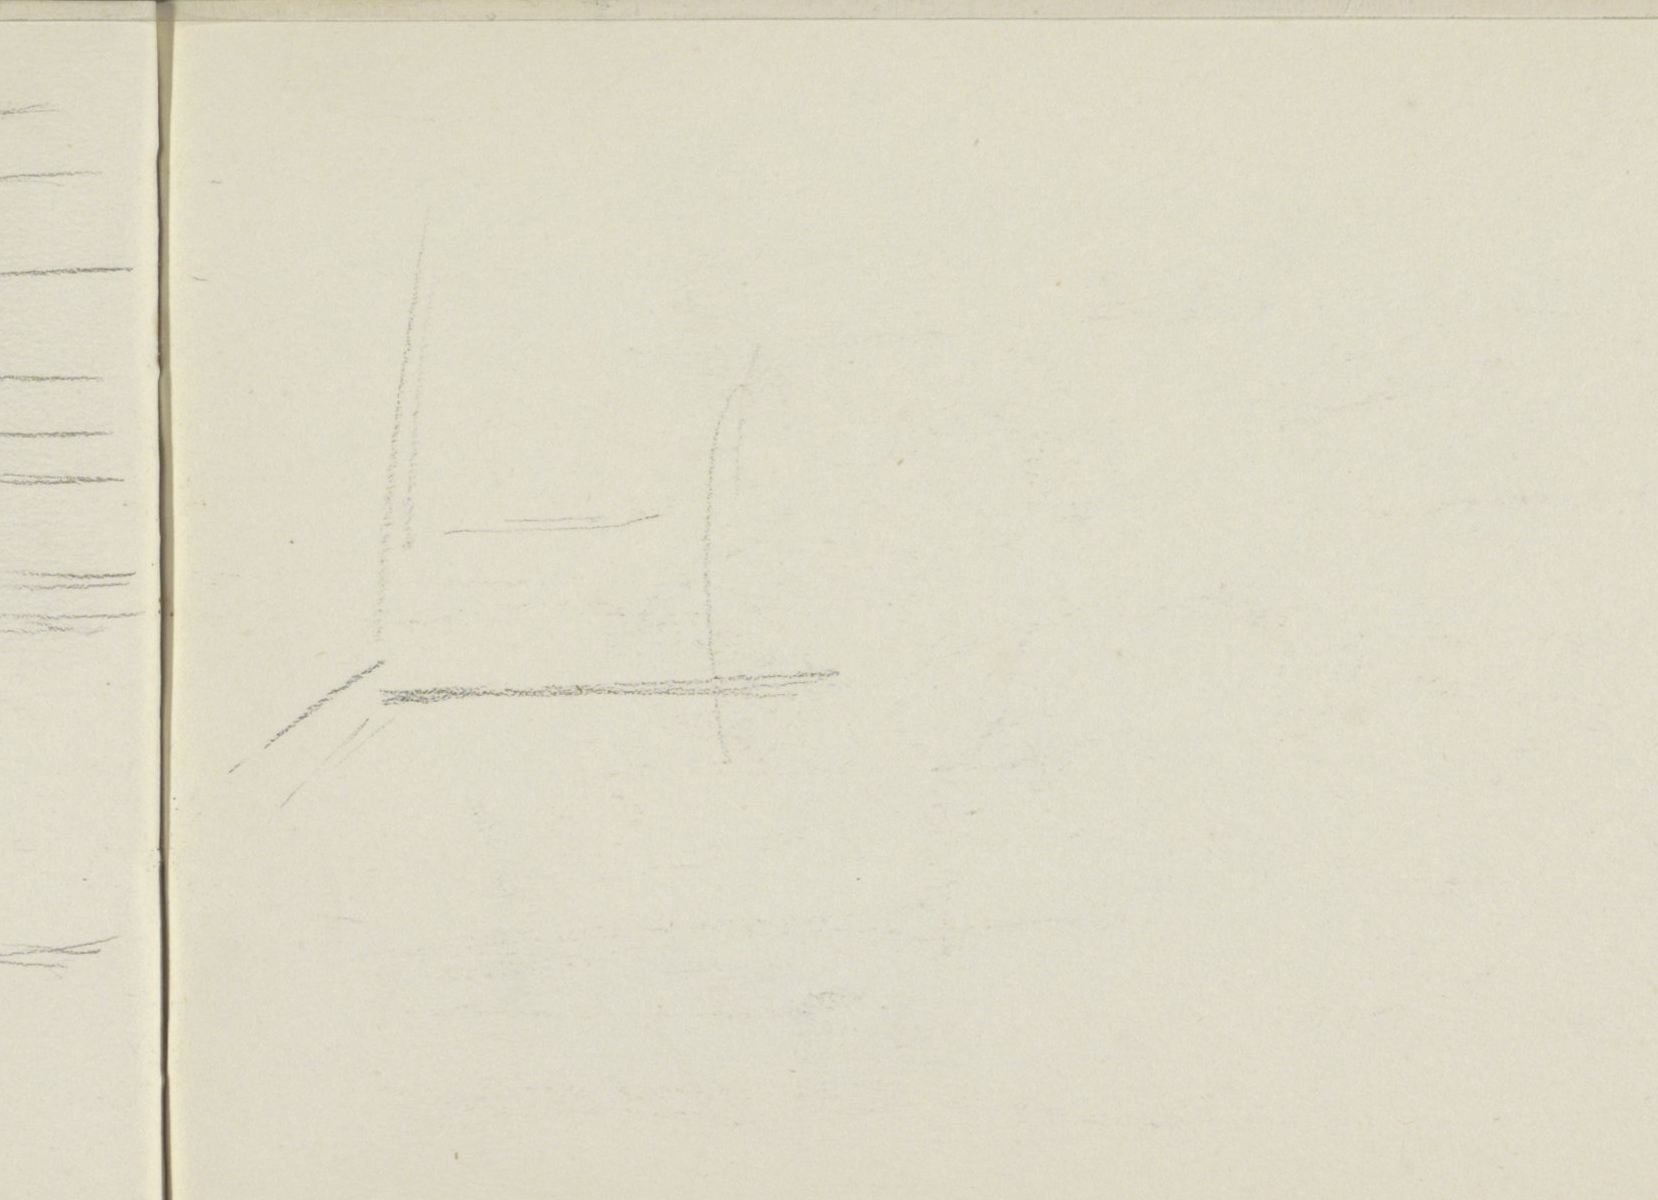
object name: sketchbook leaf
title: Studie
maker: a.a.l. de grammont-hubrecht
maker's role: draughtsman, painter, print maker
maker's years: 1855-1913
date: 1865-1913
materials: chalk, paper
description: Blad 31 recto uit een schetsboek met 38 bladen.